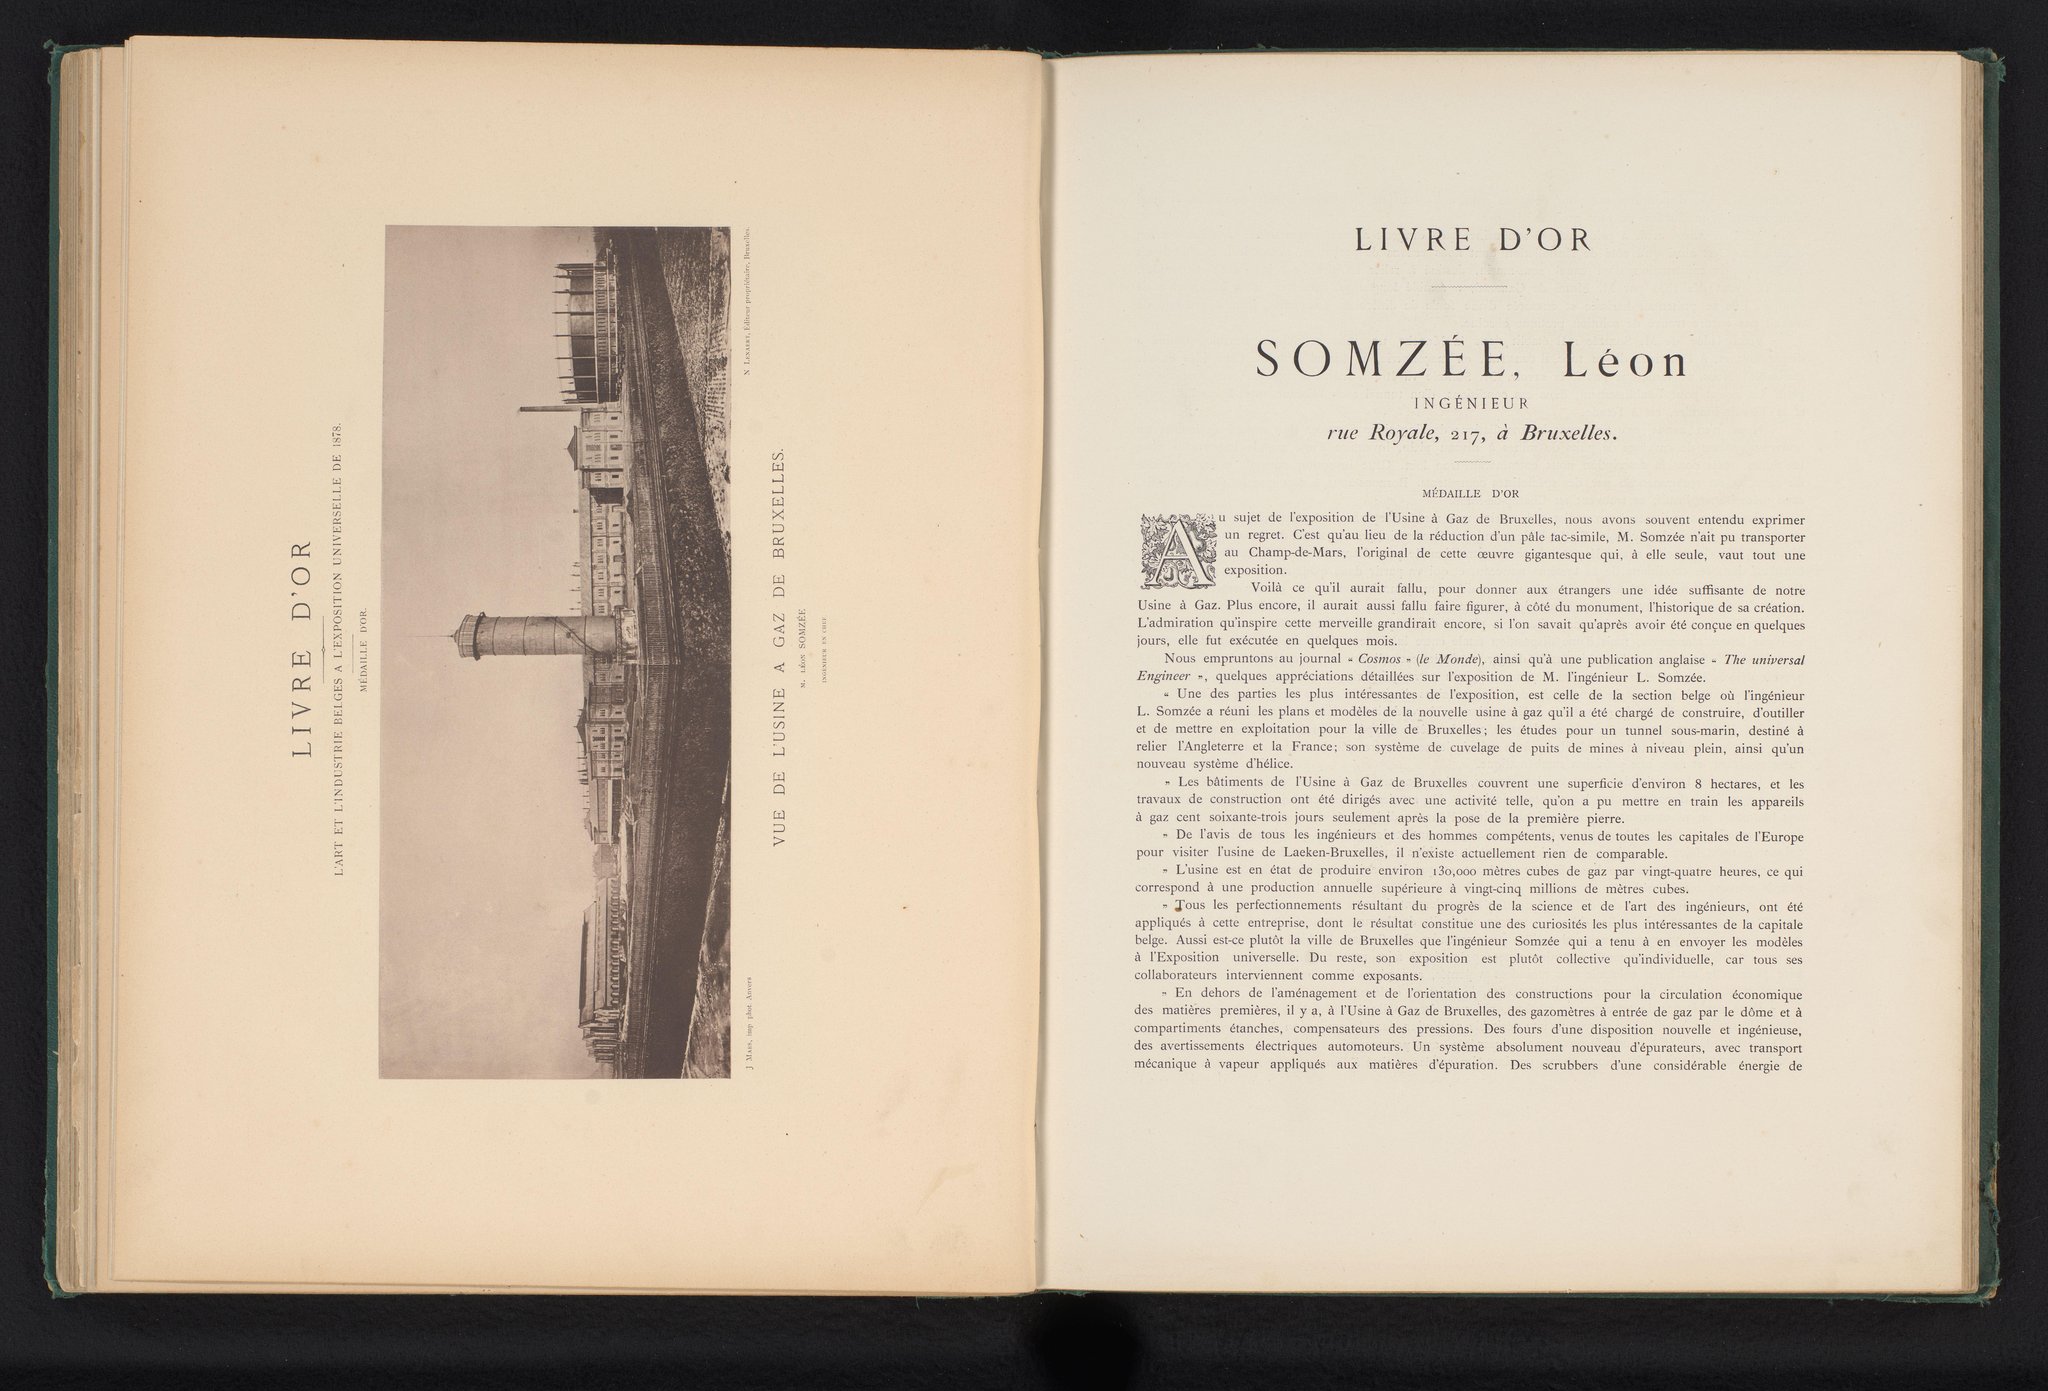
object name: photomechanical print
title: Gezicht op de gasfabriek te Brussel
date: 1874-1879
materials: paper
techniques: photograph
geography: antwerp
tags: gasworks, factory in landscape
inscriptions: inscription: ‘Livre d'or/ L'art et l'industrie Belges a l'exposition universelle de 1878.’